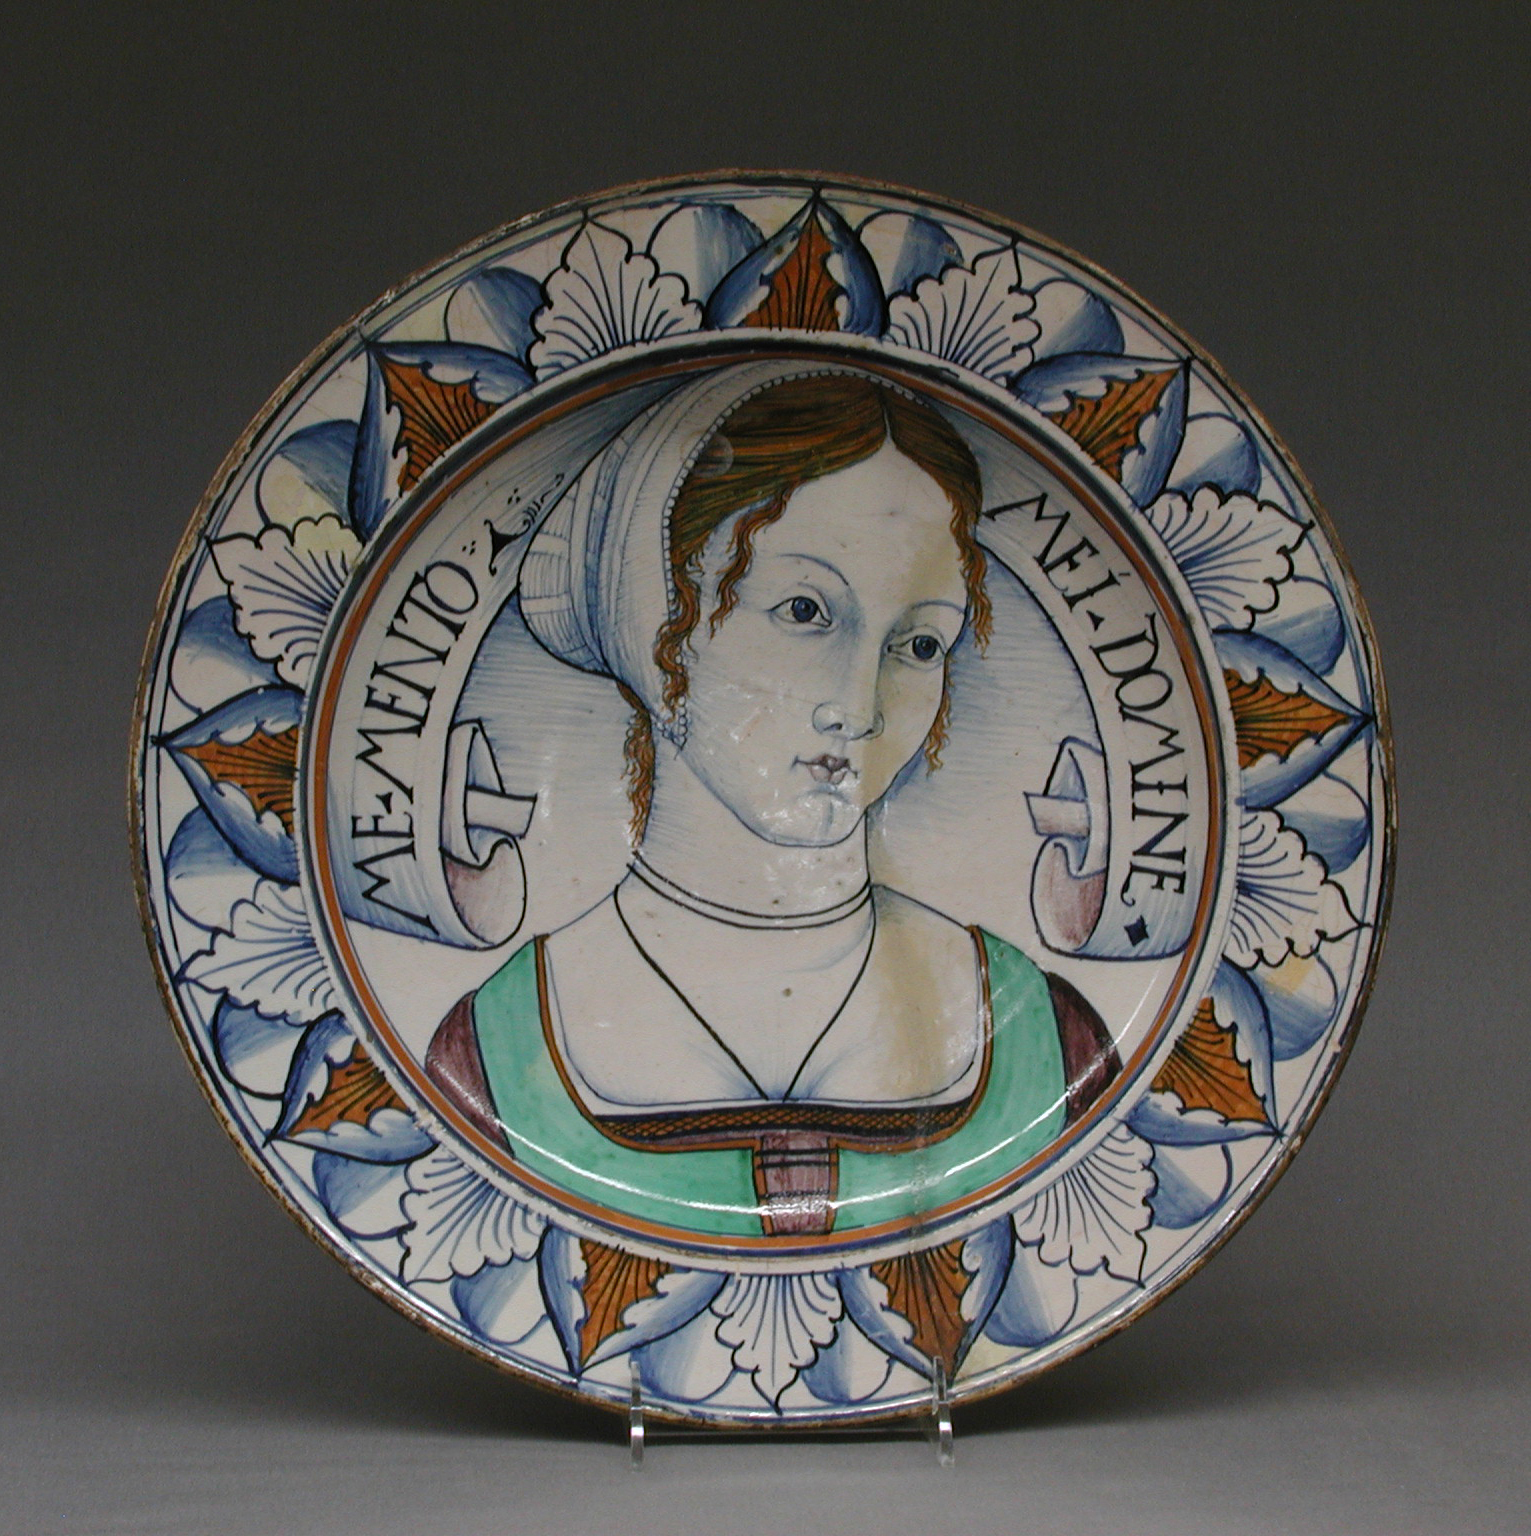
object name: dish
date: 1801-1900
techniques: maiolica, glazing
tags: portraits,women